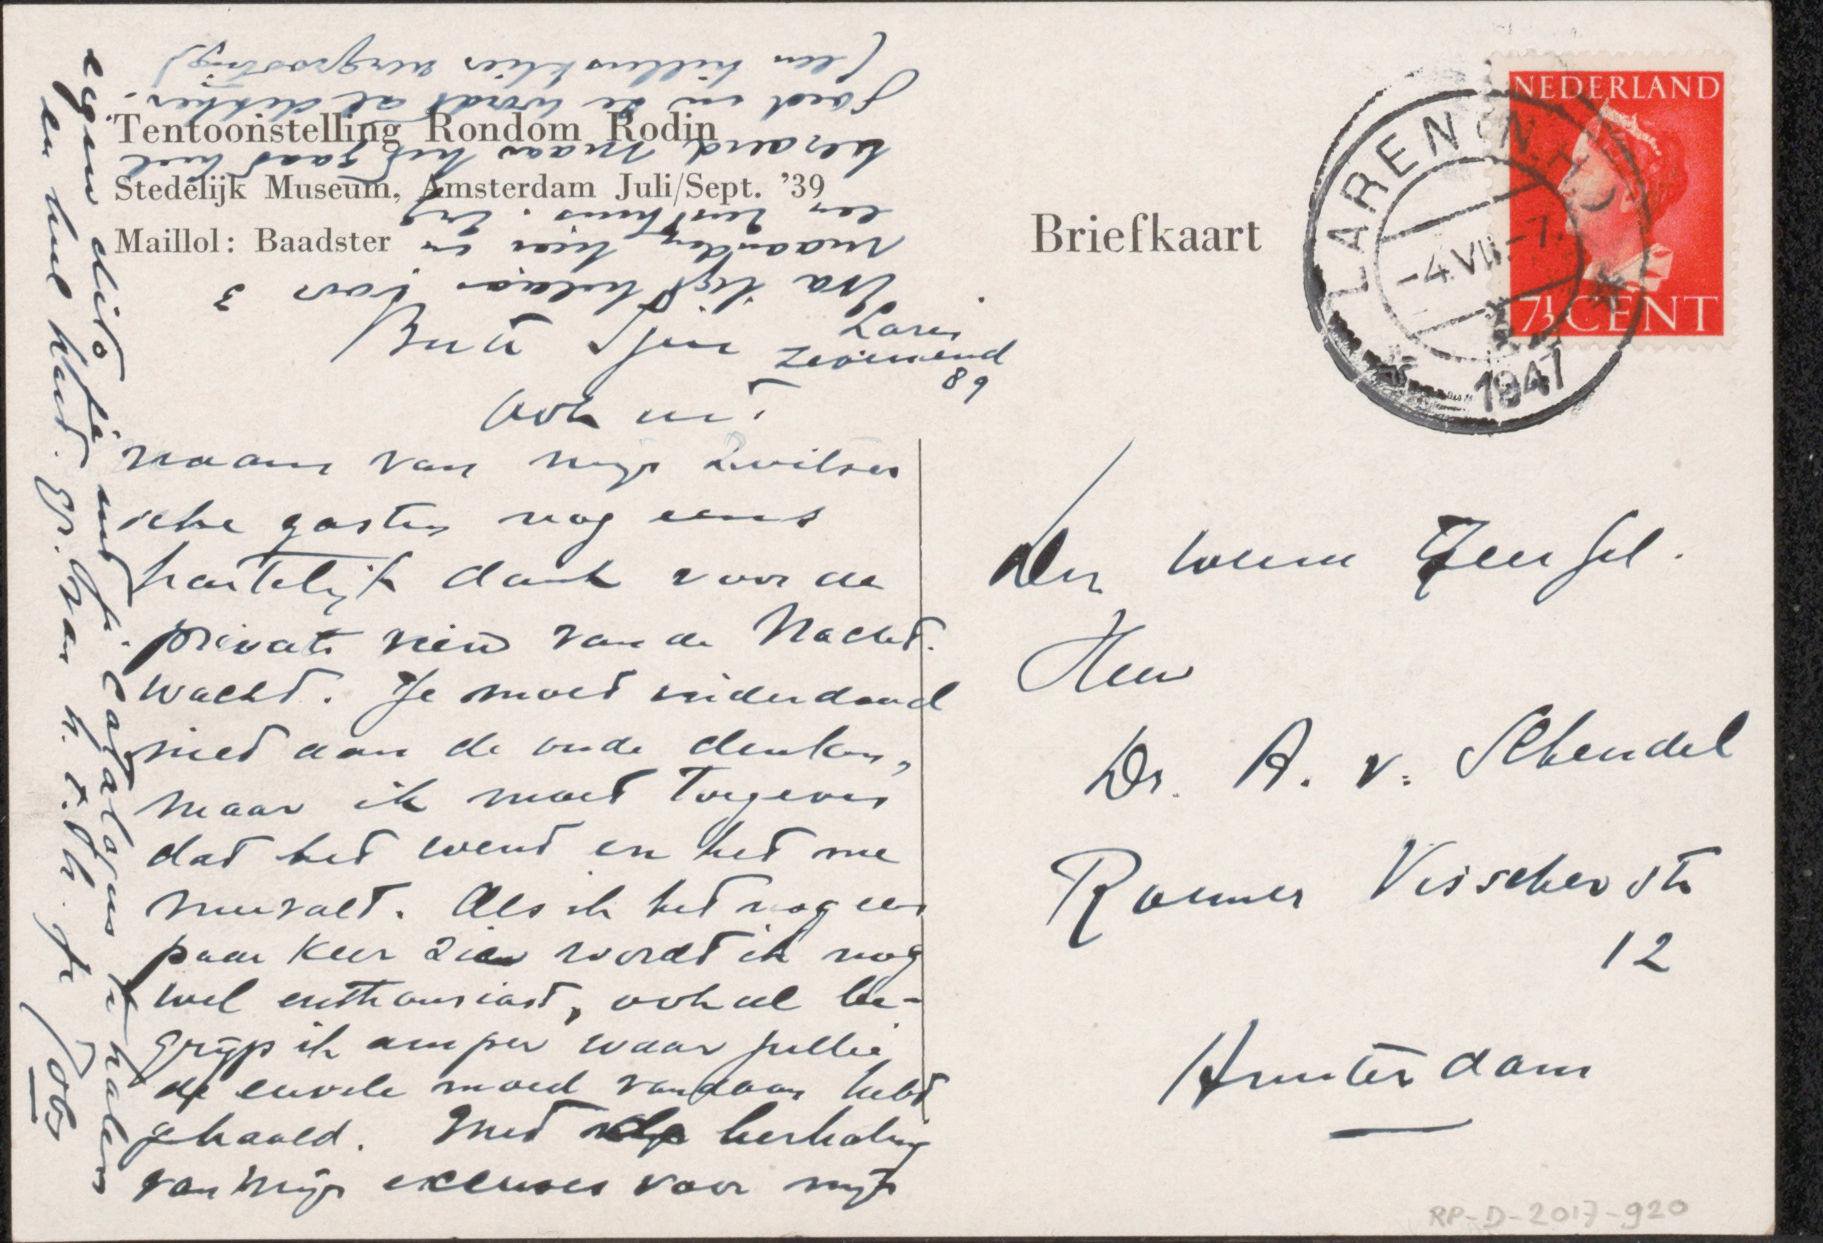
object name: ansichtkaart, prentbriefkaart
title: Prentbriefkaart aan Arthur François Emile van Schendel jr.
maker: Anonymous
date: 1947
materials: cardboard, ink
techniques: pen, writing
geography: laren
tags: leiden, amsterdam, painter, print maker, draughtsman, rembrandt van rijn, arthur françois emile van schendel jr., painting (including book-illumination, miniature-painting), diseases